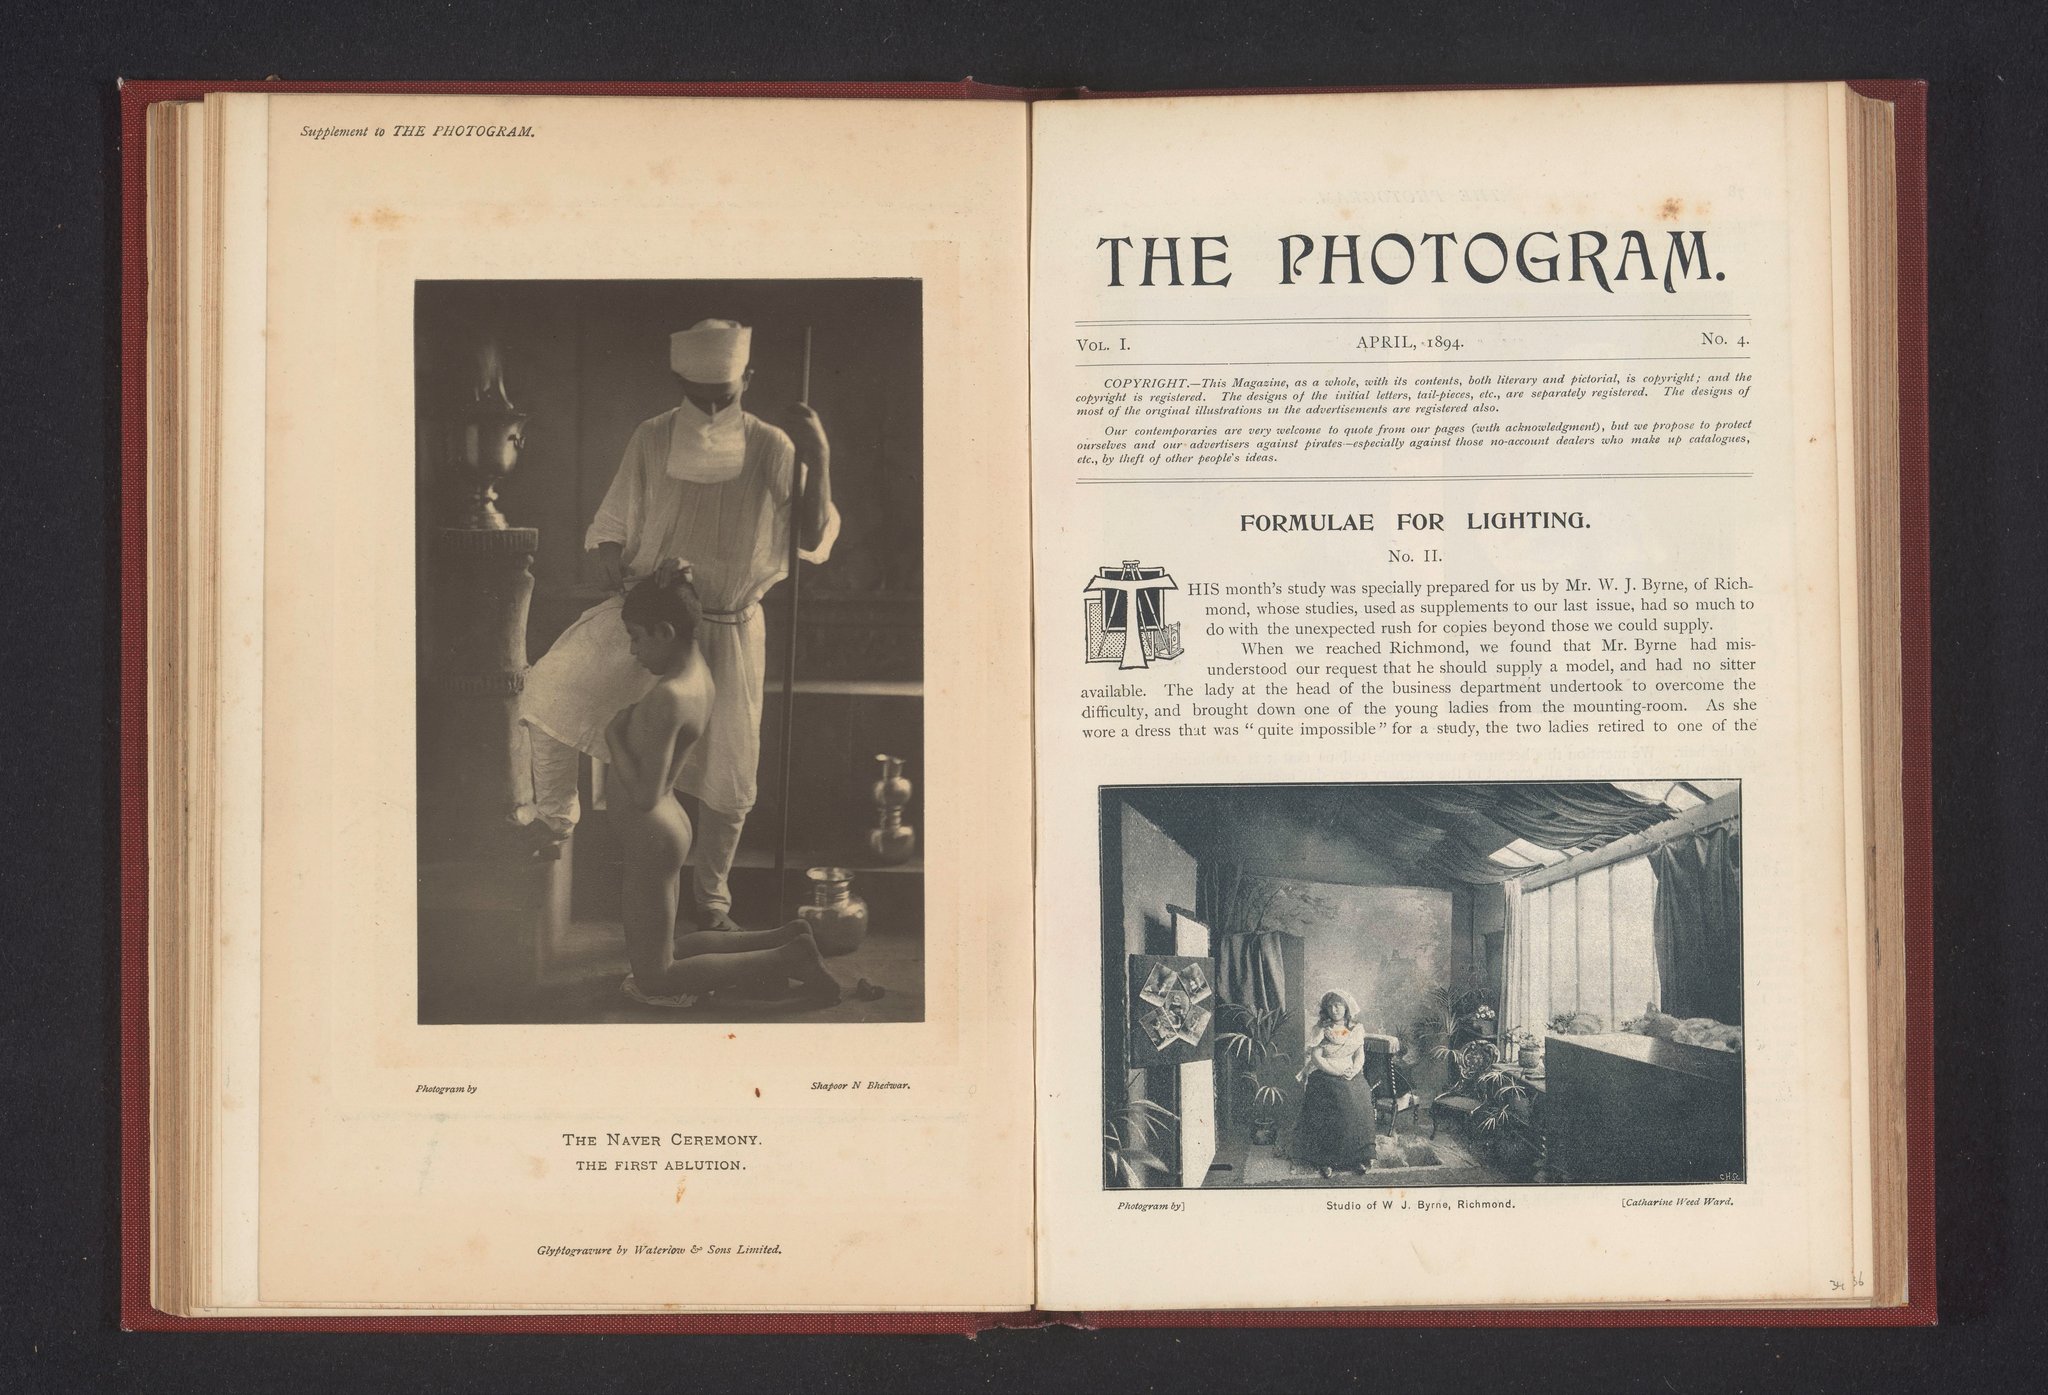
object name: photomechanical print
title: Studio of W.J. Byrne, Richmond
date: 1889-1894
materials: paper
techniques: autotype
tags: studio ~ photographer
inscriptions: inscription: ‘The first ablution’